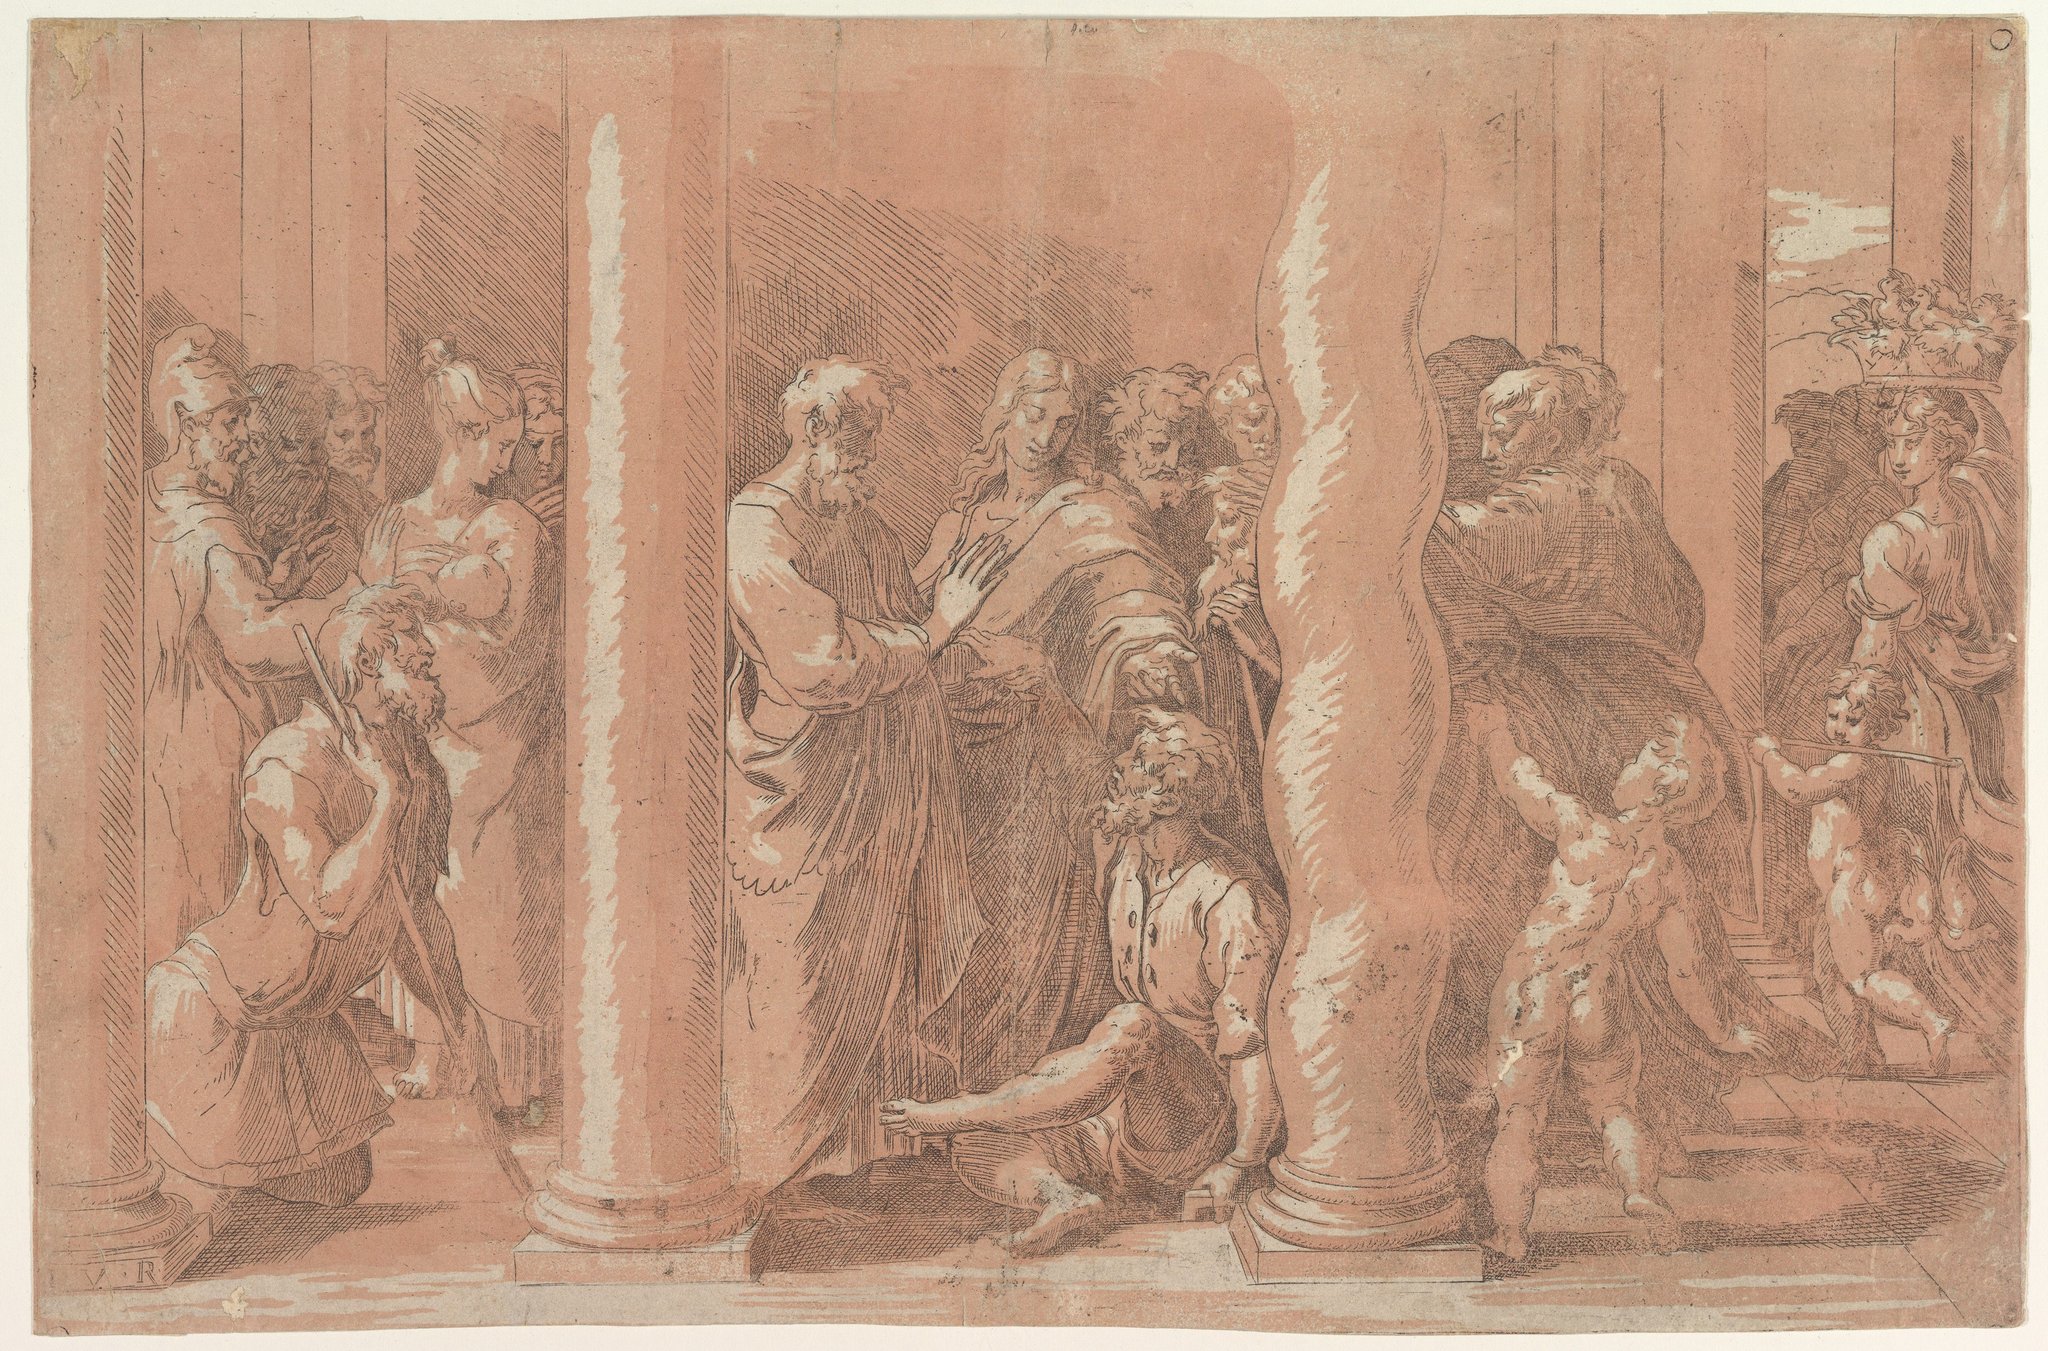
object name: print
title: Saints Peter and John healing the Sick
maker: parmigianino (girolamo francesco maria mazzola)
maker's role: artist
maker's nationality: italian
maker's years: 1503-1540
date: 1501-1600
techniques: etching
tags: illness,children,women,saint peter,saints